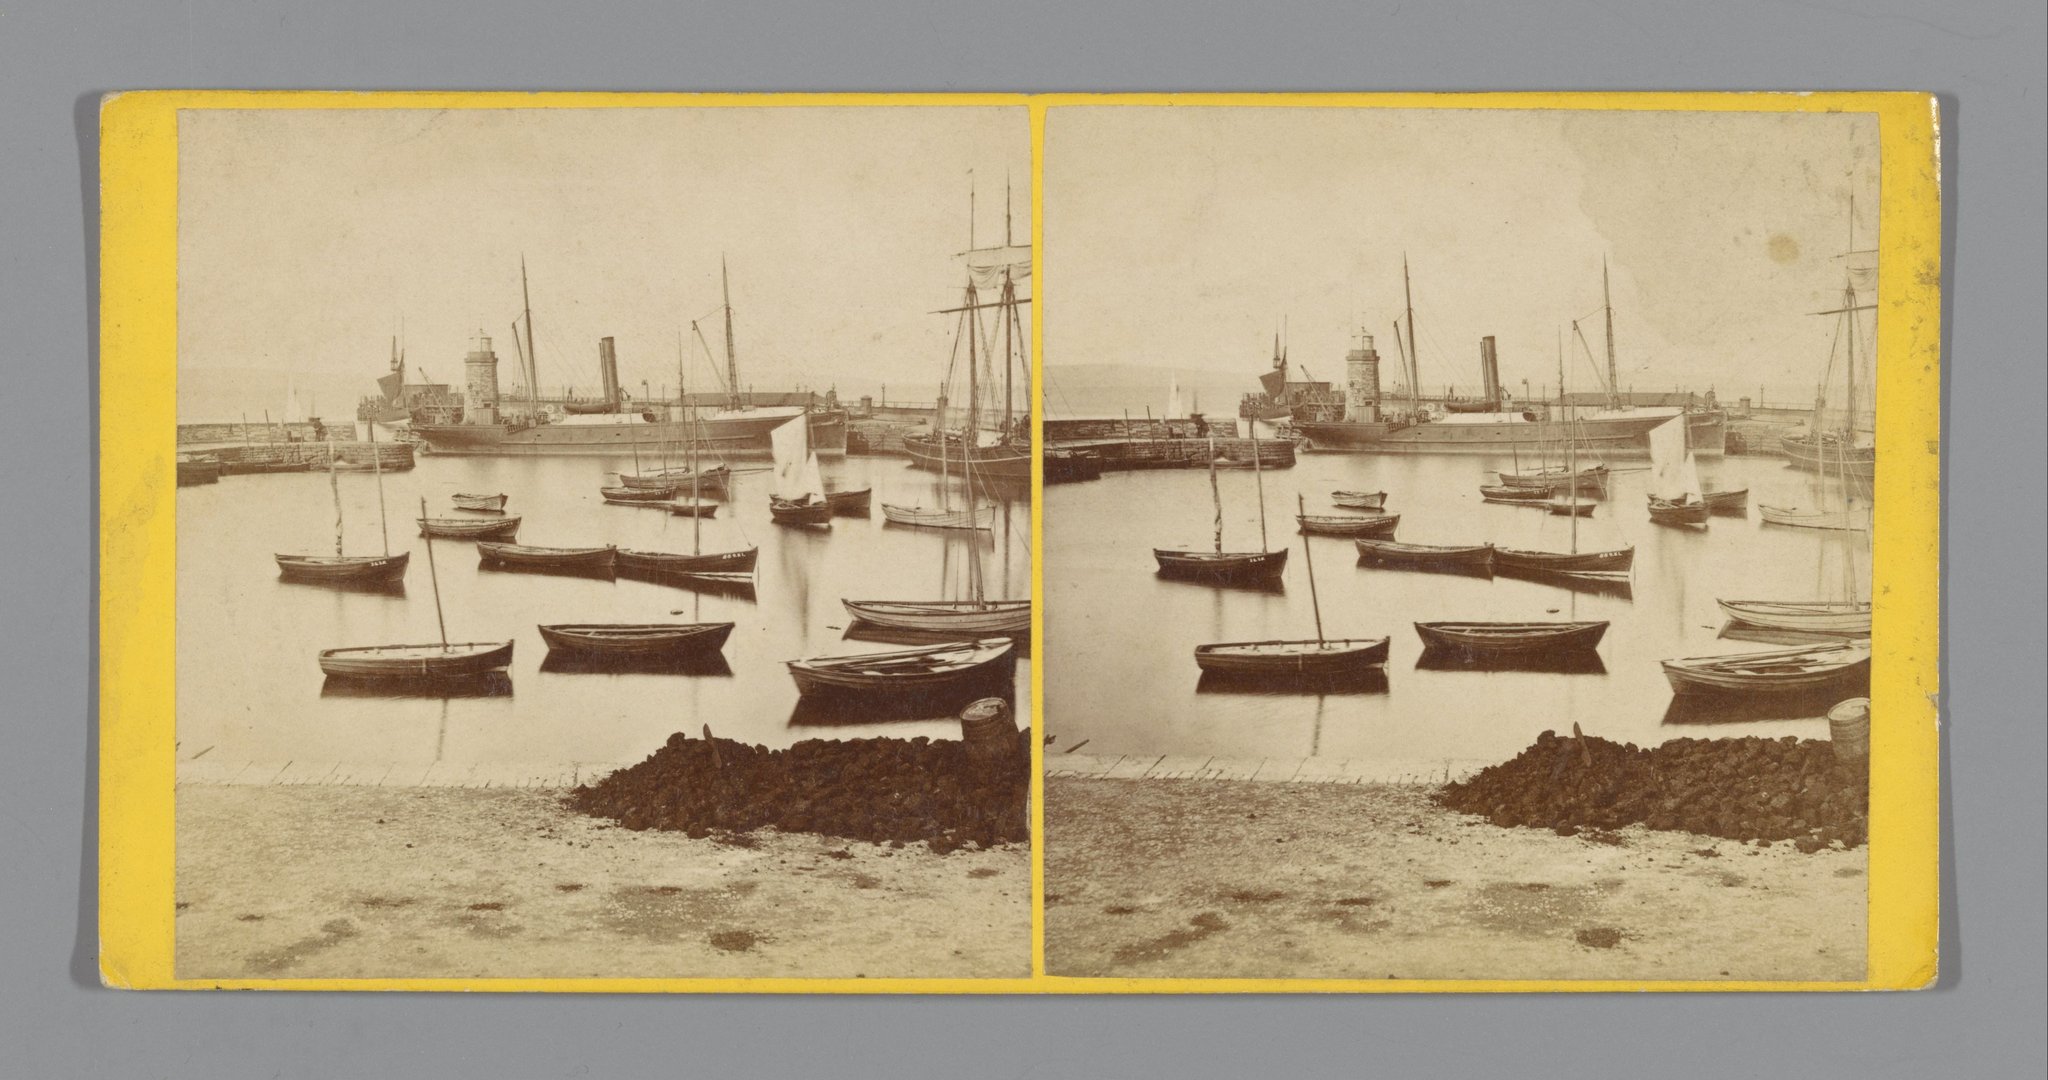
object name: stereograph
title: Kirkwall Harbour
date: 1850-1880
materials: cardboard, photographic support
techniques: albumen print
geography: kirkwall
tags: harbour, ships (in general) - cc - more than one ship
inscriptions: inscription: ‘Scottish Scenery.’, name: ‘Photographed By G. W. Wilson & Co., Aberdeen.’